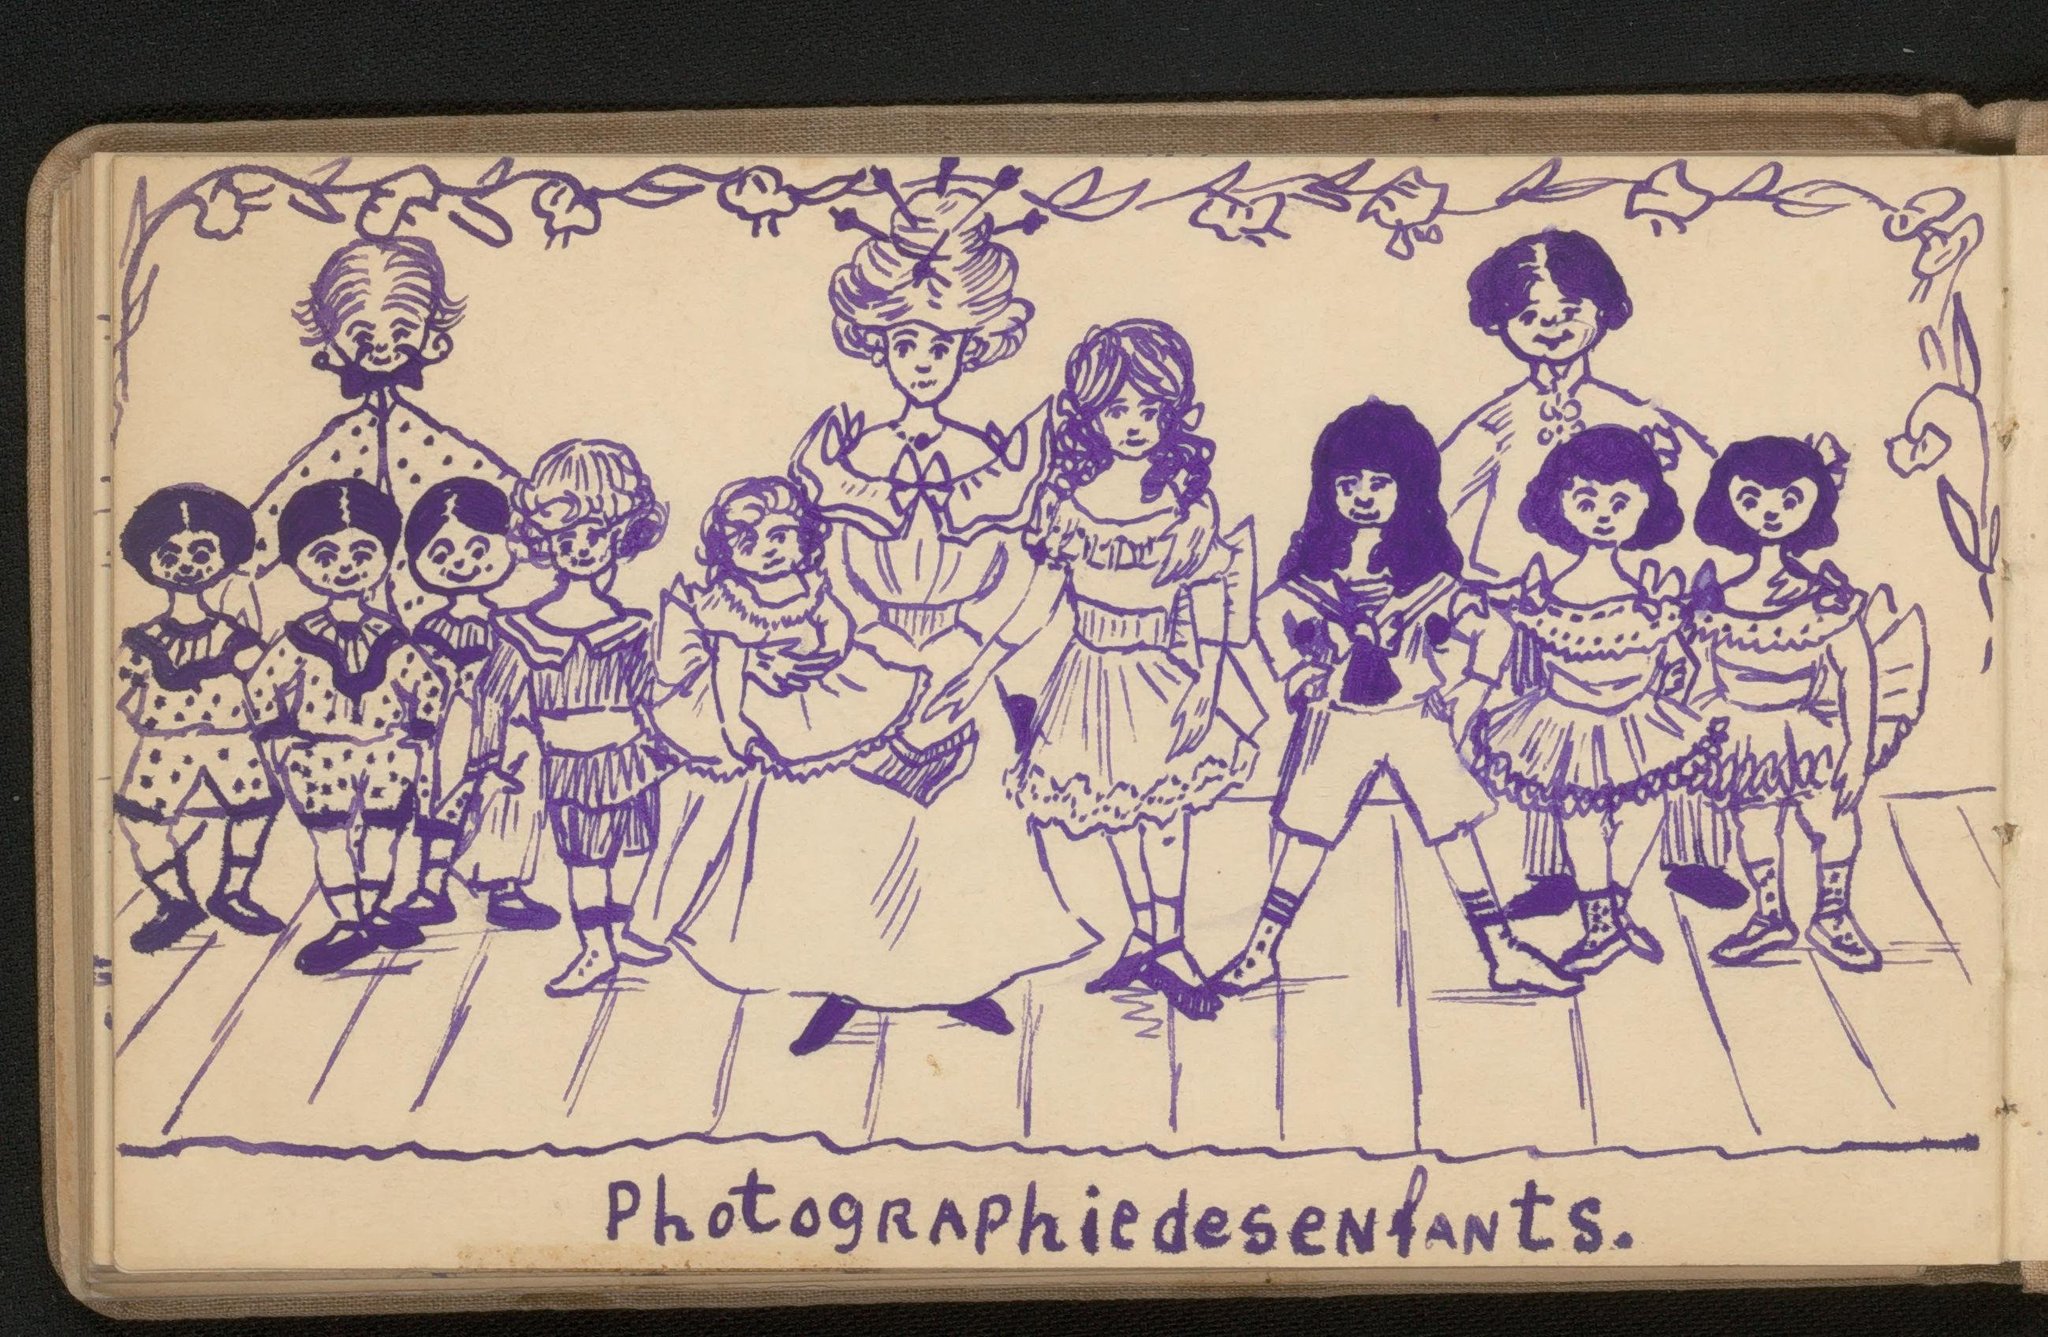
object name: sketchbook leaf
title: Photographie des enfants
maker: Anonymous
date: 1875-1920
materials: ink, paper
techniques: pen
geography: netherlands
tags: family life at home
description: Groepsfoto van het hele gezin. Onderdeel van het schetsboek met humoristische tekeningen over het leven van een 'famille nombreuse'. Onderwerpsrubrieken binnen de Atlas Zeden en Gewoonten: Zeden en Gewoonten in Engeren Zin, Des menschen beging, midden en einde, Kinderleven.